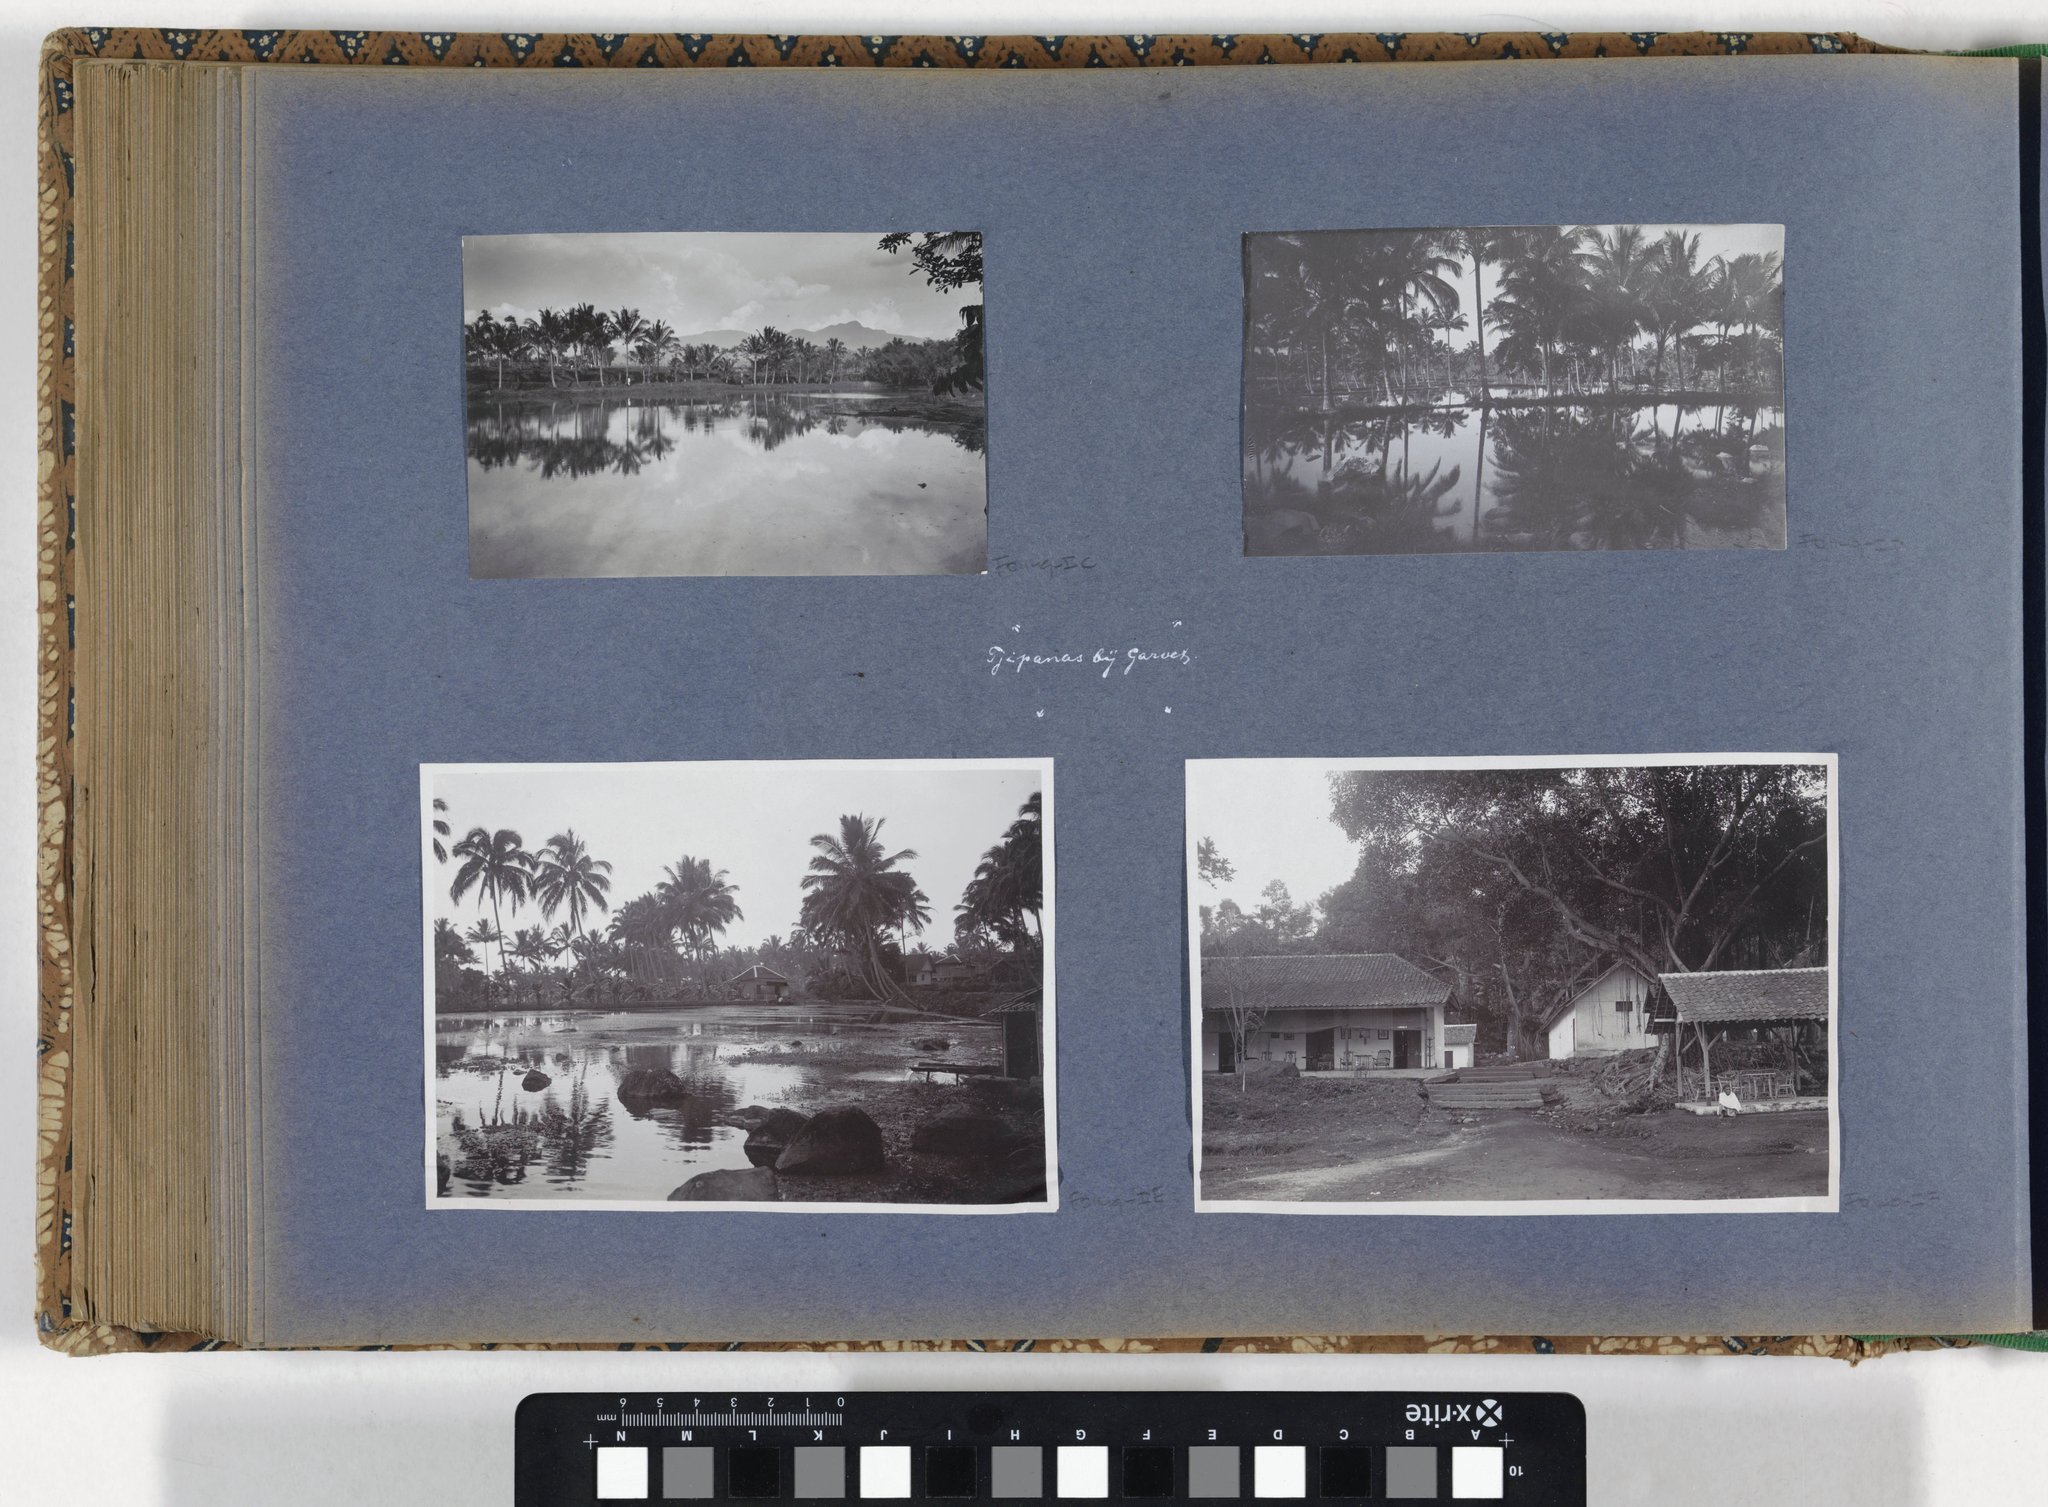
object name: album leaf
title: Huizen bij Tjisoeroepan op Java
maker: Anonymous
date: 1900-1920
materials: paper, photographic support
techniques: gelatin silver print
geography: java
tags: rural housing, e.g. country-house, villa, cottage, java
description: Onderdeel van reisalbum met foto's van bedrijvigheid en bezienswaardigheden op Sumatra en Java en van de reis naar en van Nederlands-Indië.